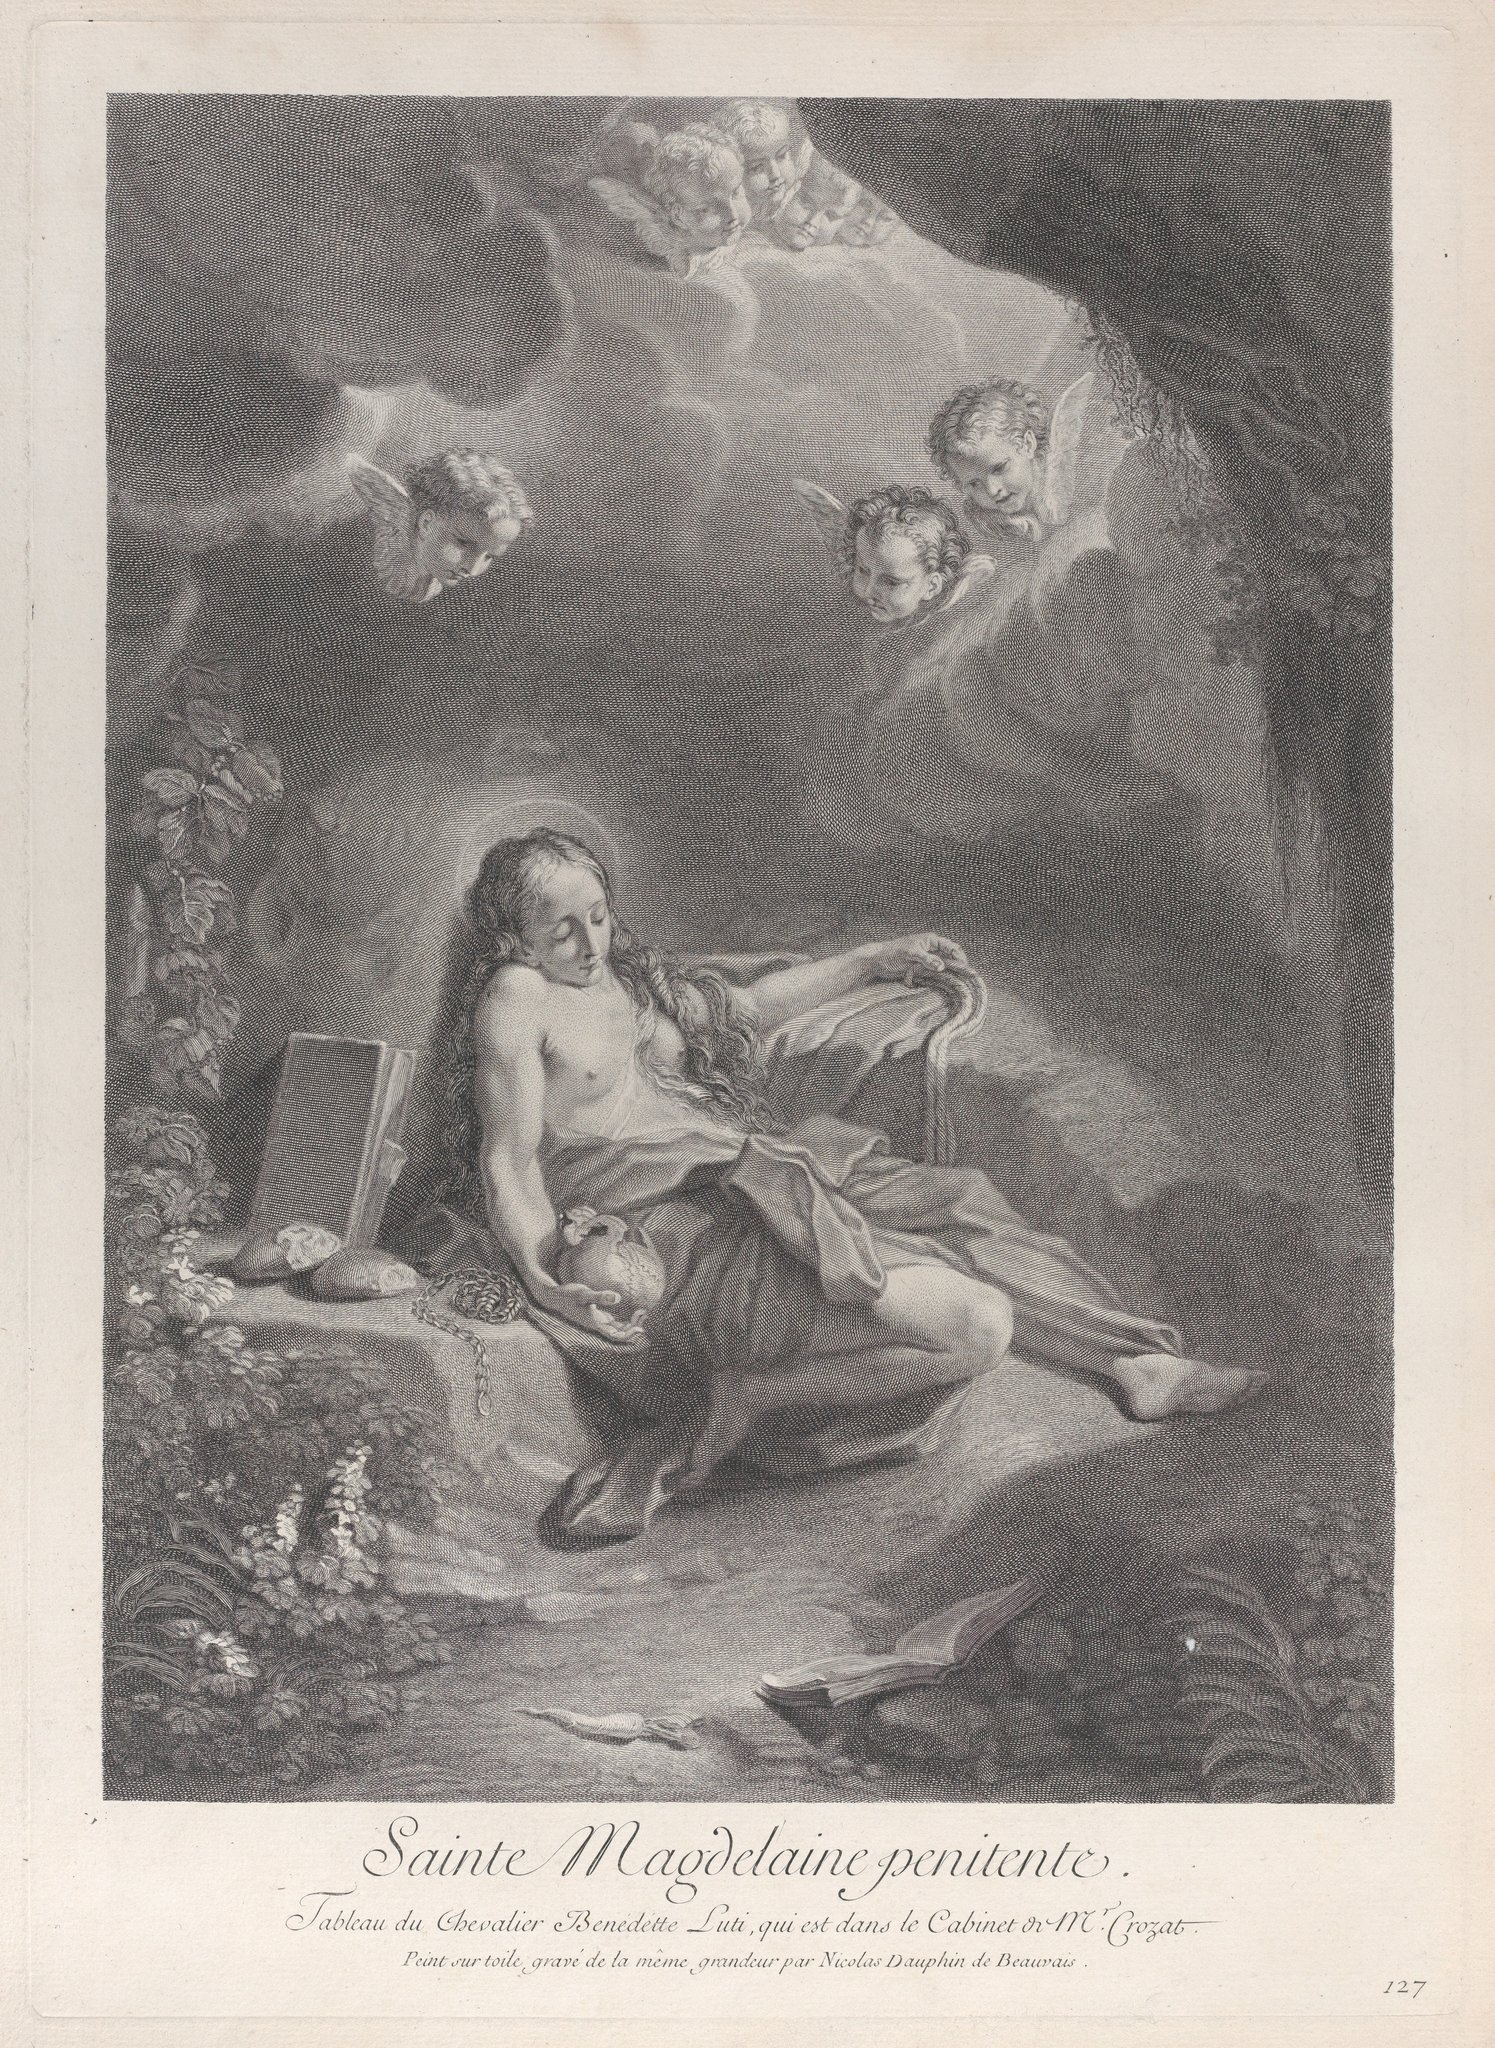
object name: print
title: The Holy Family with Saint Elizabeth and angels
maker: nicolas dauphin de beauvais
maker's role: artist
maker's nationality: french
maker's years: 1687-1763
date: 1729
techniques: engraving, etching